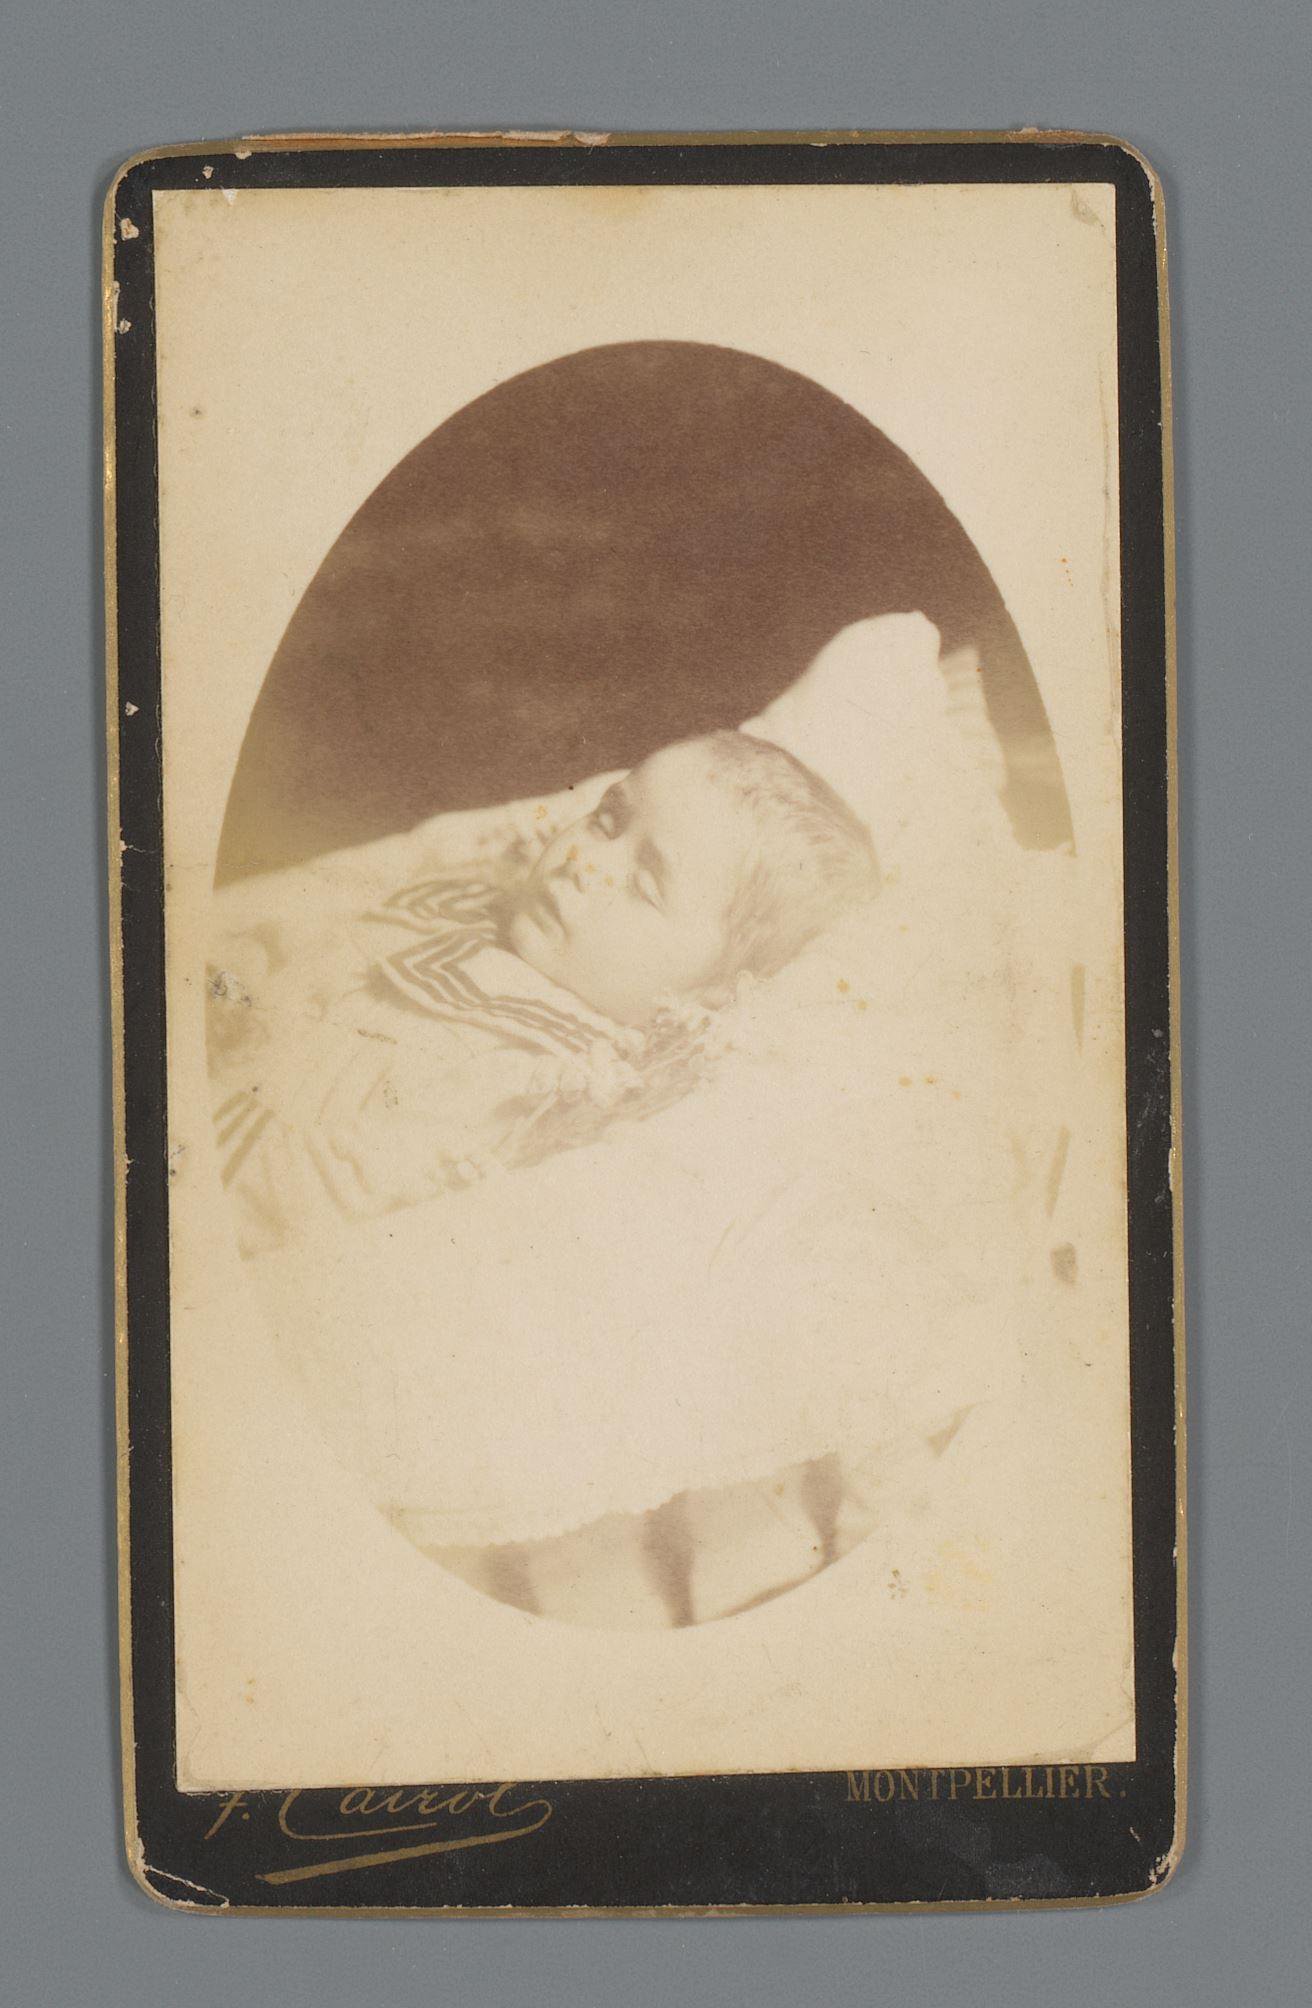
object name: carte de visite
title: Post-mortemportret van een onbekende jongen, gekleed in een matrozenpak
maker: fernand cairol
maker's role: fotograaf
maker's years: 1845-1905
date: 1858-1905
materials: cardboard, paper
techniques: albumen print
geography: montpellier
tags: boy (child between toddler and youth)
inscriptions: address: ‘Grand Rue et Rue des Etuves/ entrée Rue Massanne 2/ MONTPELLIER.’